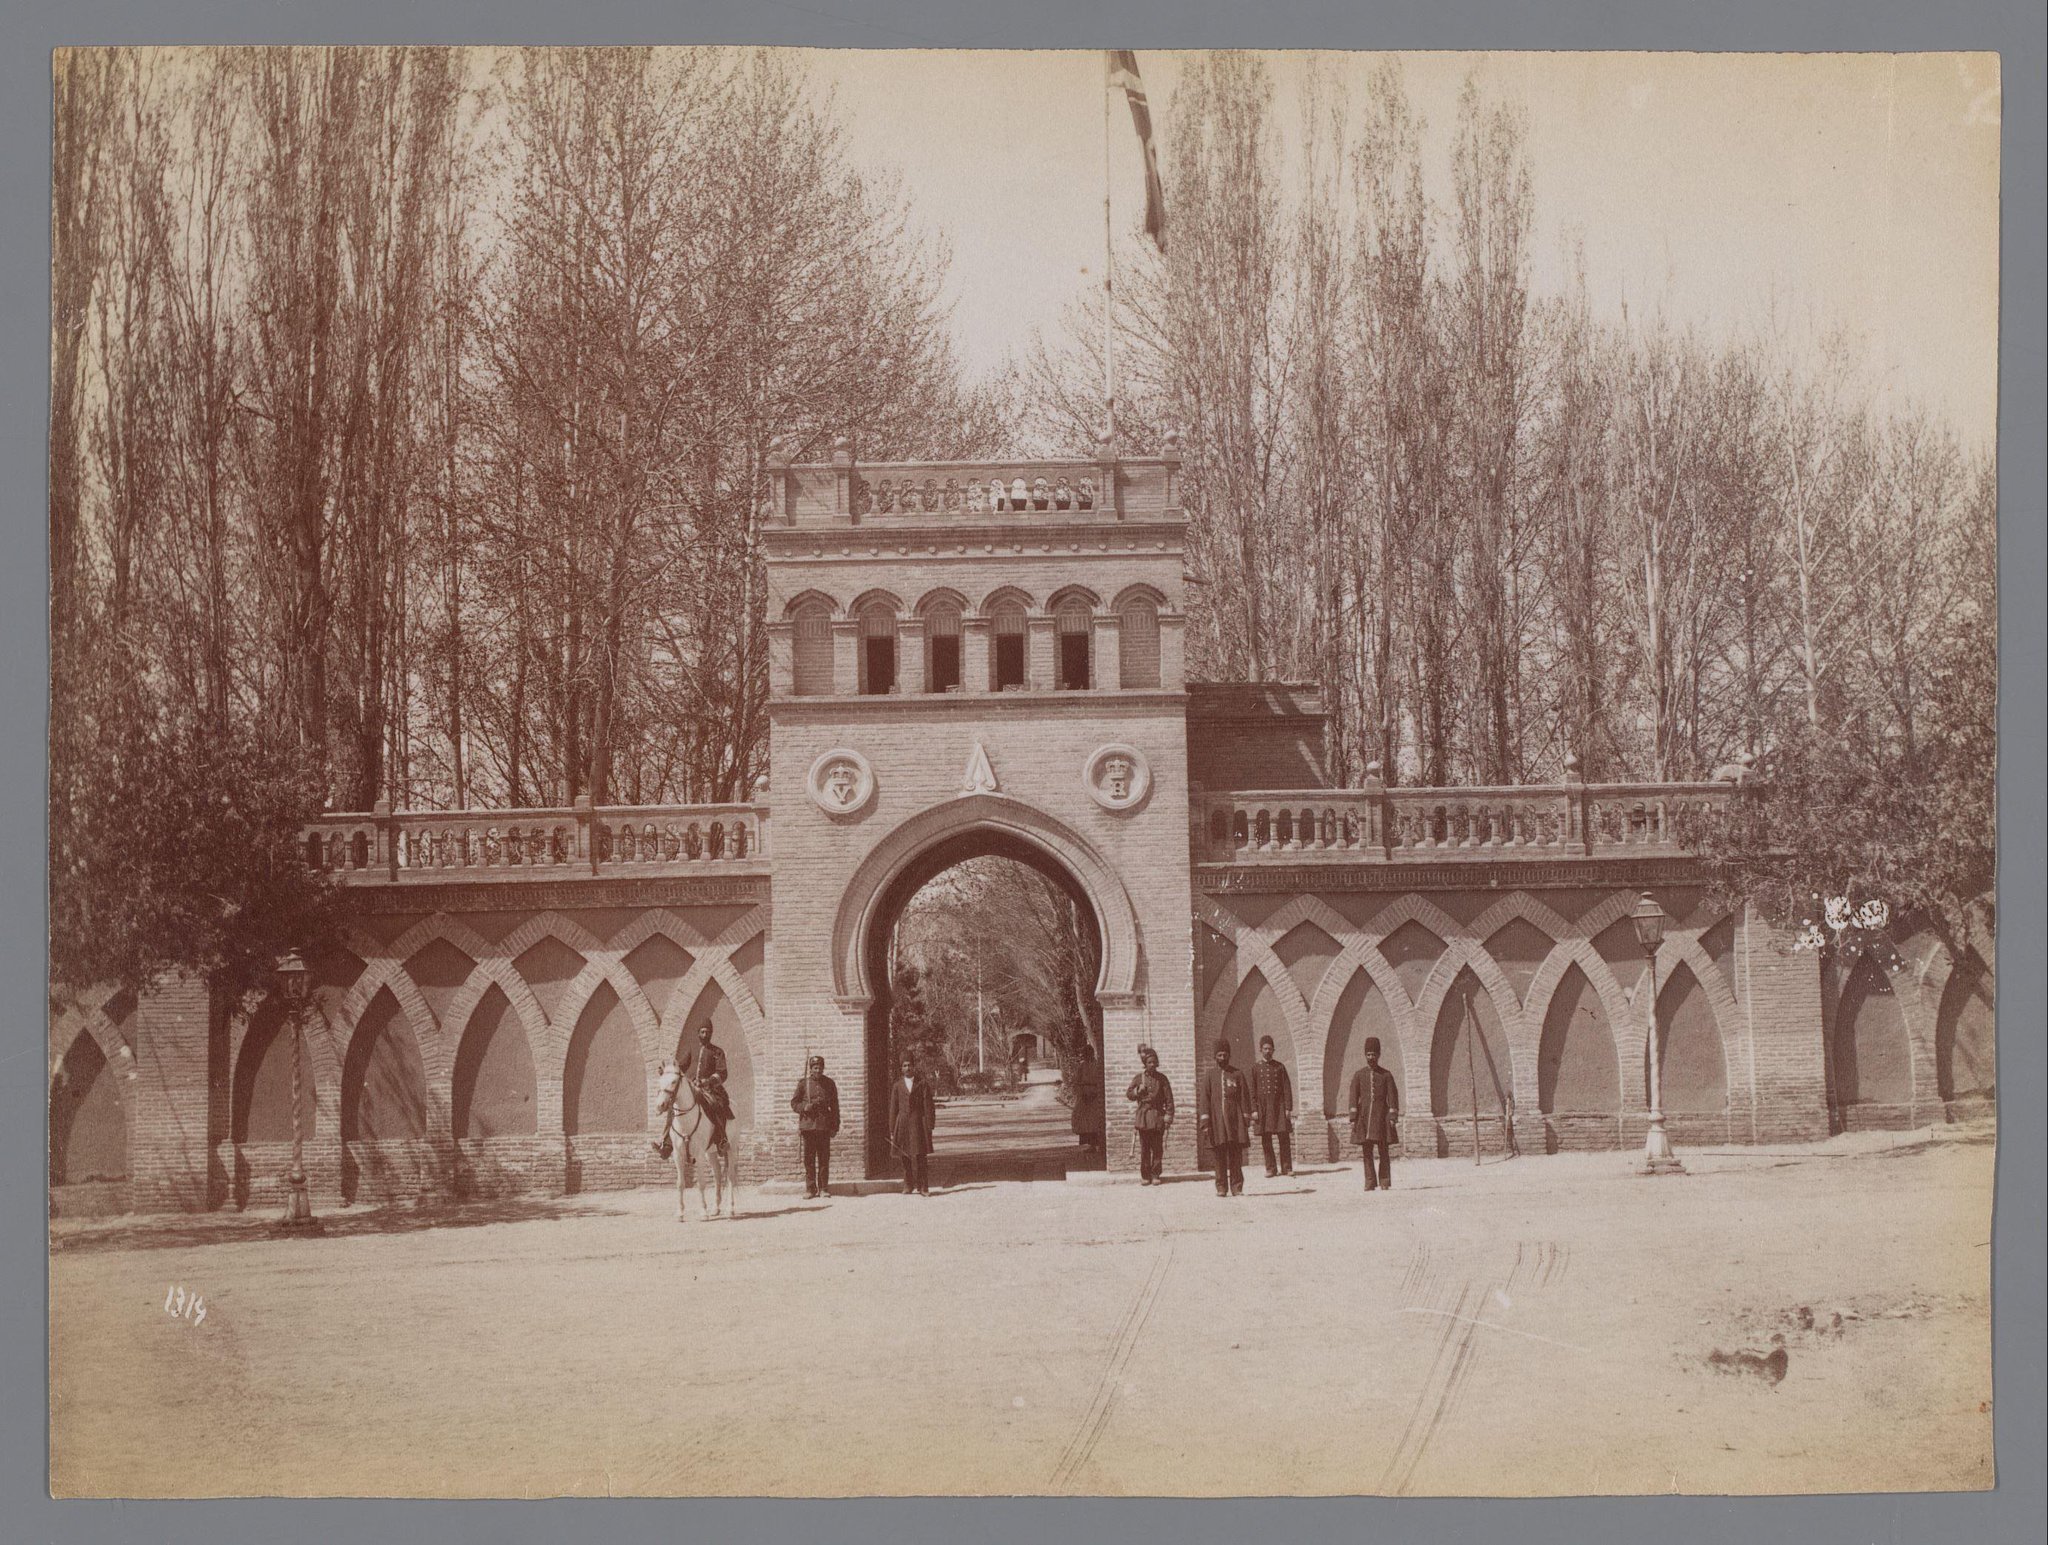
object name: photograph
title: Engels Gezantschap/ambassade, Teheran [?], Iran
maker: antoine sevruguin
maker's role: fotograaf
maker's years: 1840-1933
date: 1880-1910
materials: paper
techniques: albumen print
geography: iran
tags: iran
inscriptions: inscription: ‘Legation Anglais’, number: ‘1314’, number: ‘9.’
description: Engels Gezantschap/ambassade, Teheran [?], Iran.